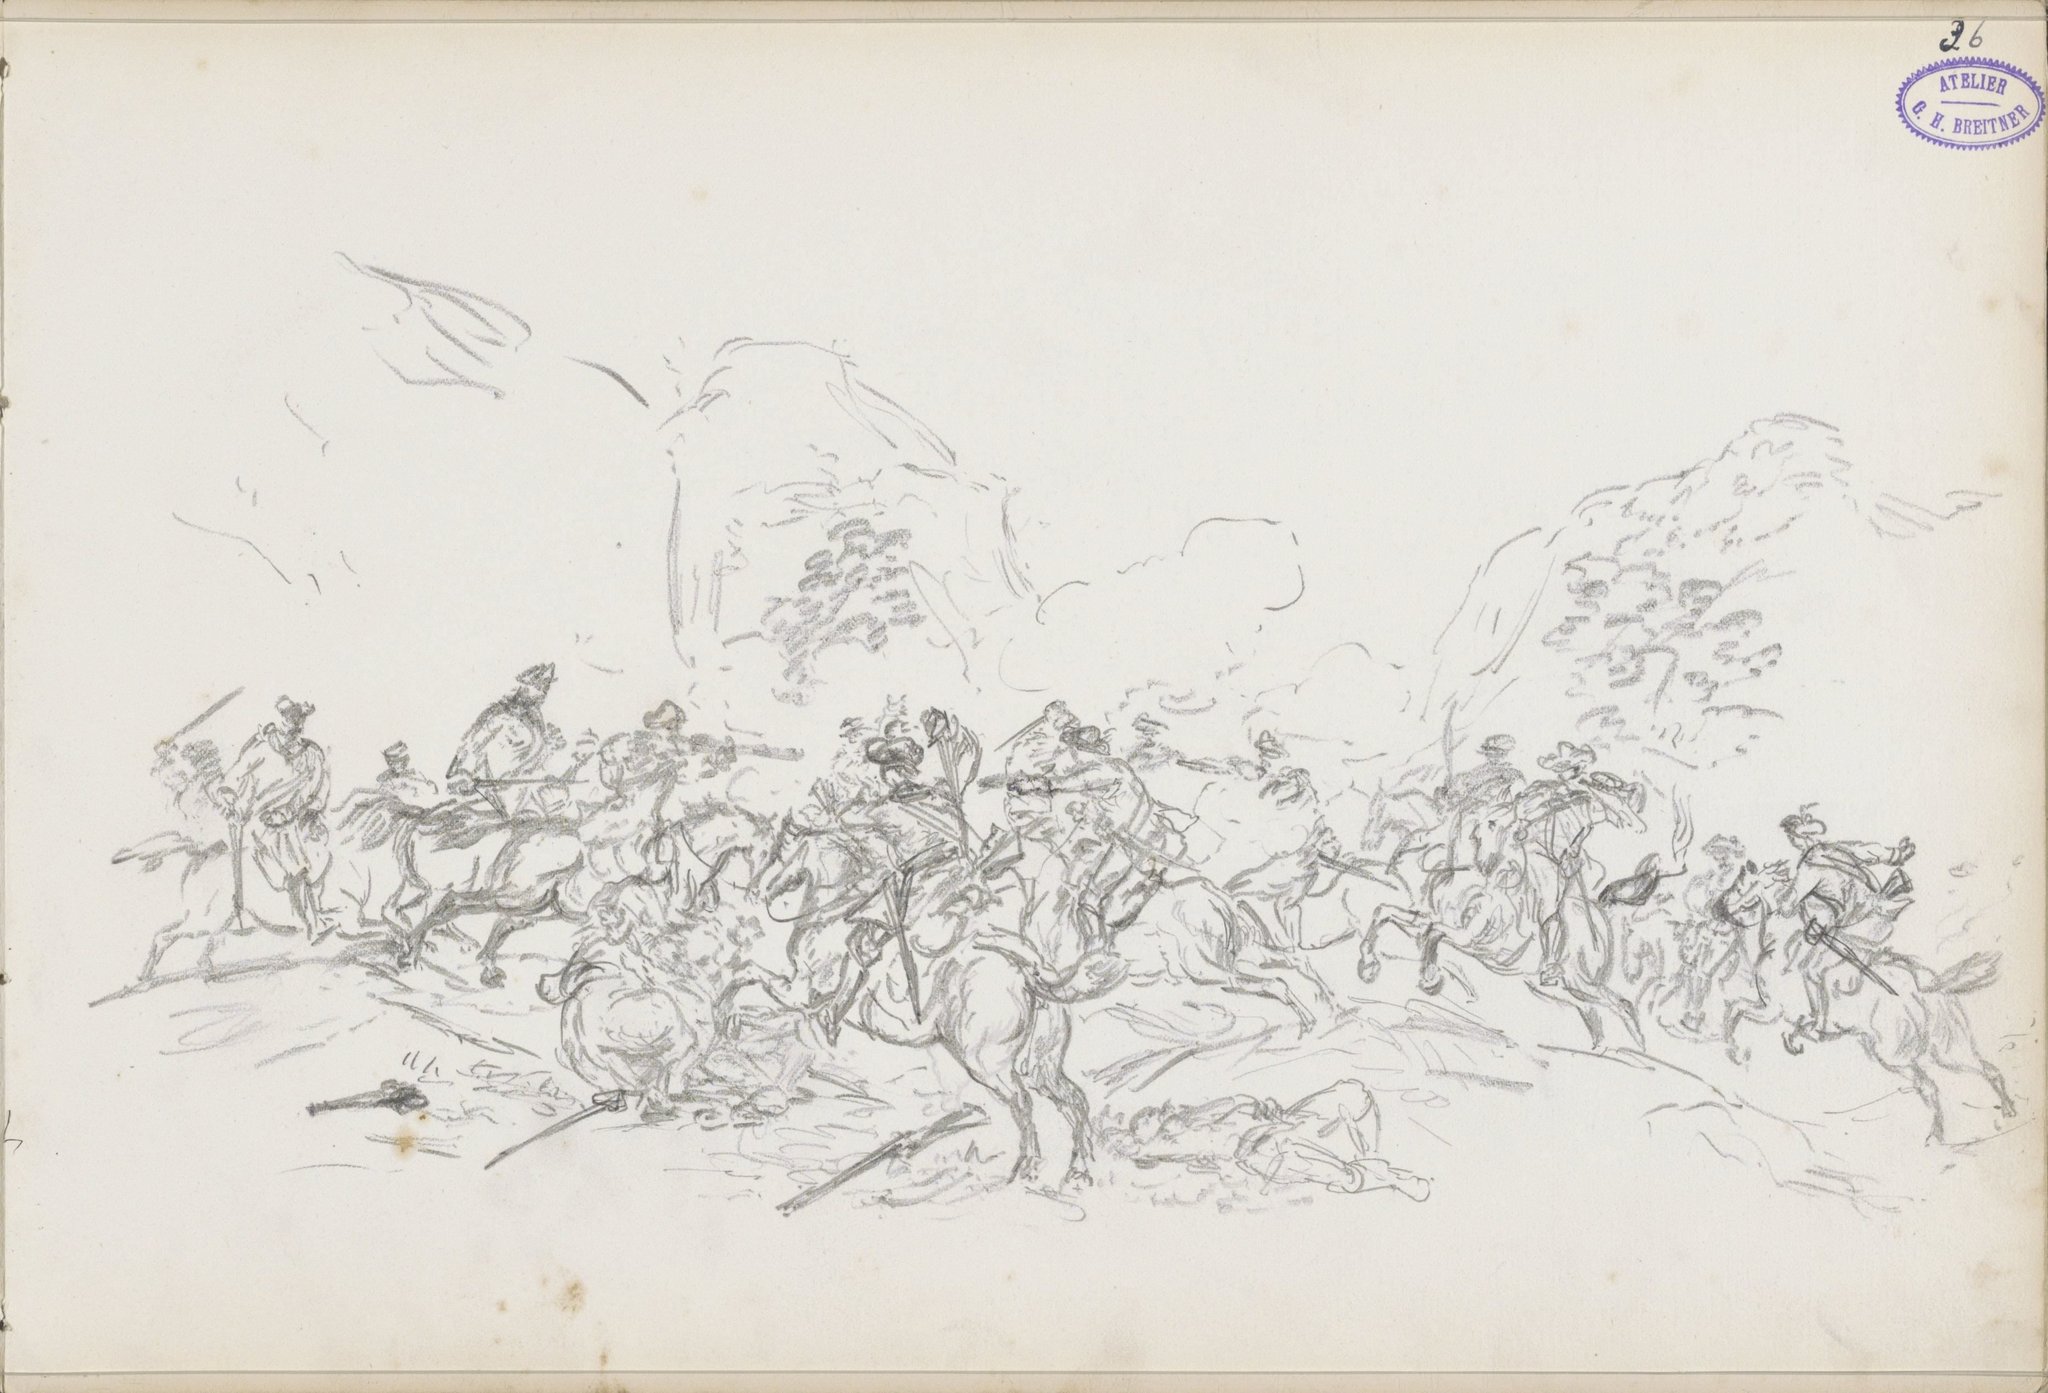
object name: sketchbook leaf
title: Strijdende soldaten te paard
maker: george hendrik breitner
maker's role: draughtsman, painter, print maker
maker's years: 1857-1923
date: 1809-1872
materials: paper, pencil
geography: rotterdam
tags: landscapes, division of armed forces (+ during the battle), division of armed forces (+ land forces)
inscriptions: workshop stamp: Lugt 291d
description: Blad 36 recto uit een schetsboek met 32 bladen.